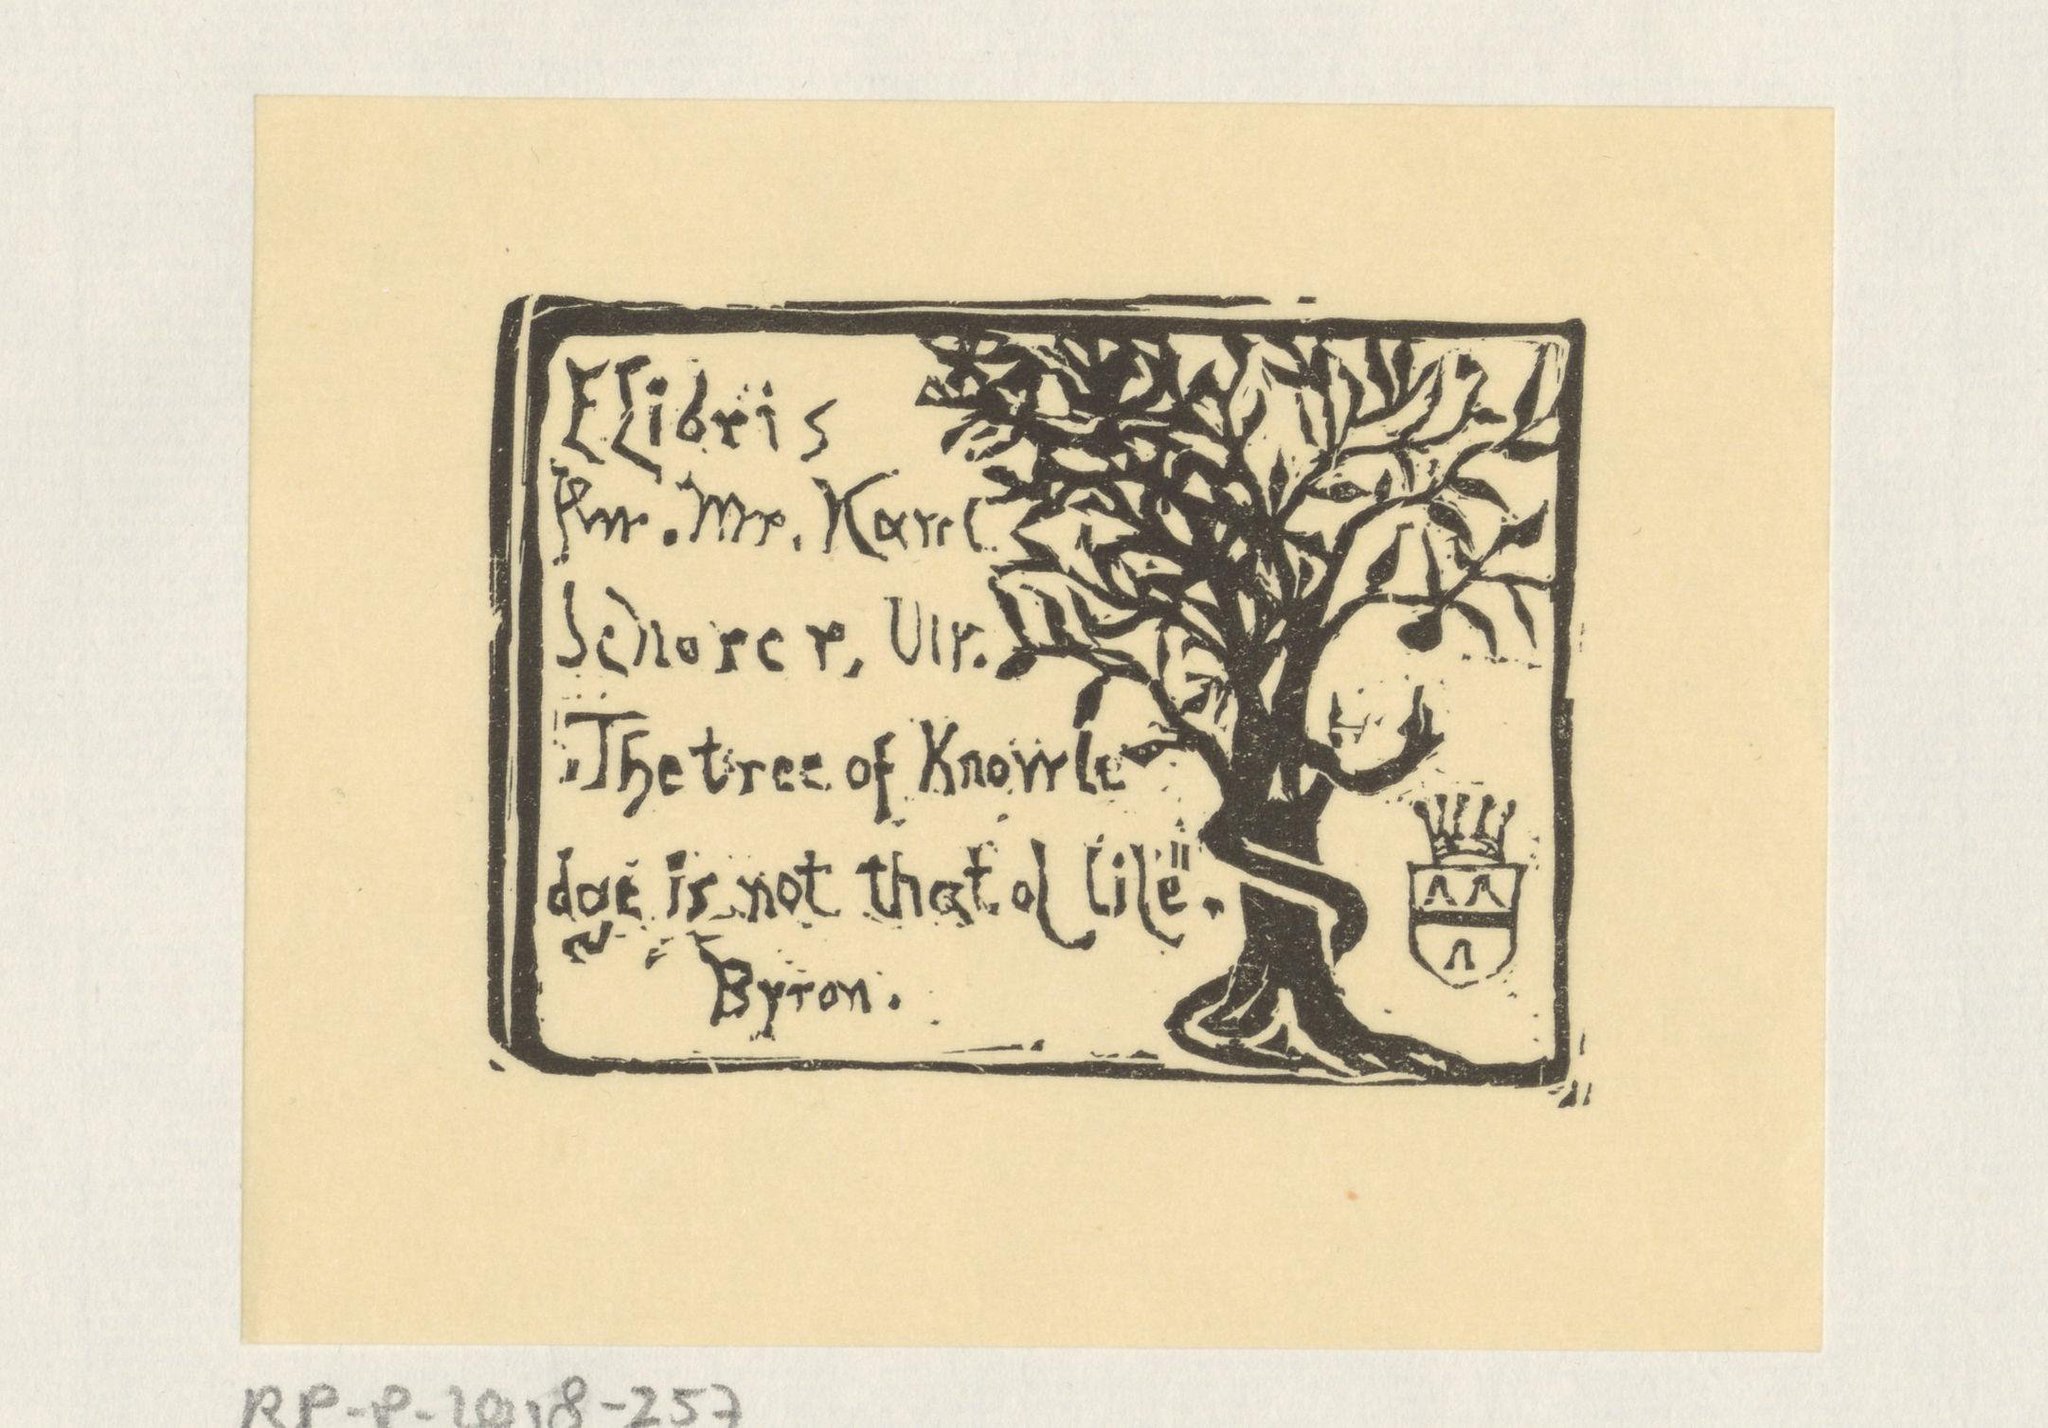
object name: bookplate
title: Ex libris van Karel Schorer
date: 1880-1940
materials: paper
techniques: woodcut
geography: netherlands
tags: karel johan schorer, the tree of knowledge of good and evil (whose fruit, usually apples or figs, brings death); the tree may be guarded by the serpent, armorial bearing, heraldry